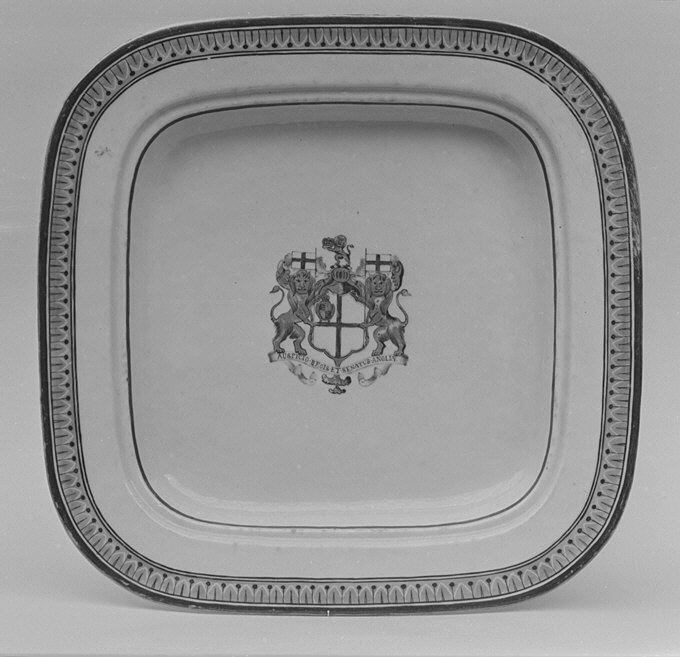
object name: dish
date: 1770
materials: hard paste porcelain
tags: lions,coat of arms